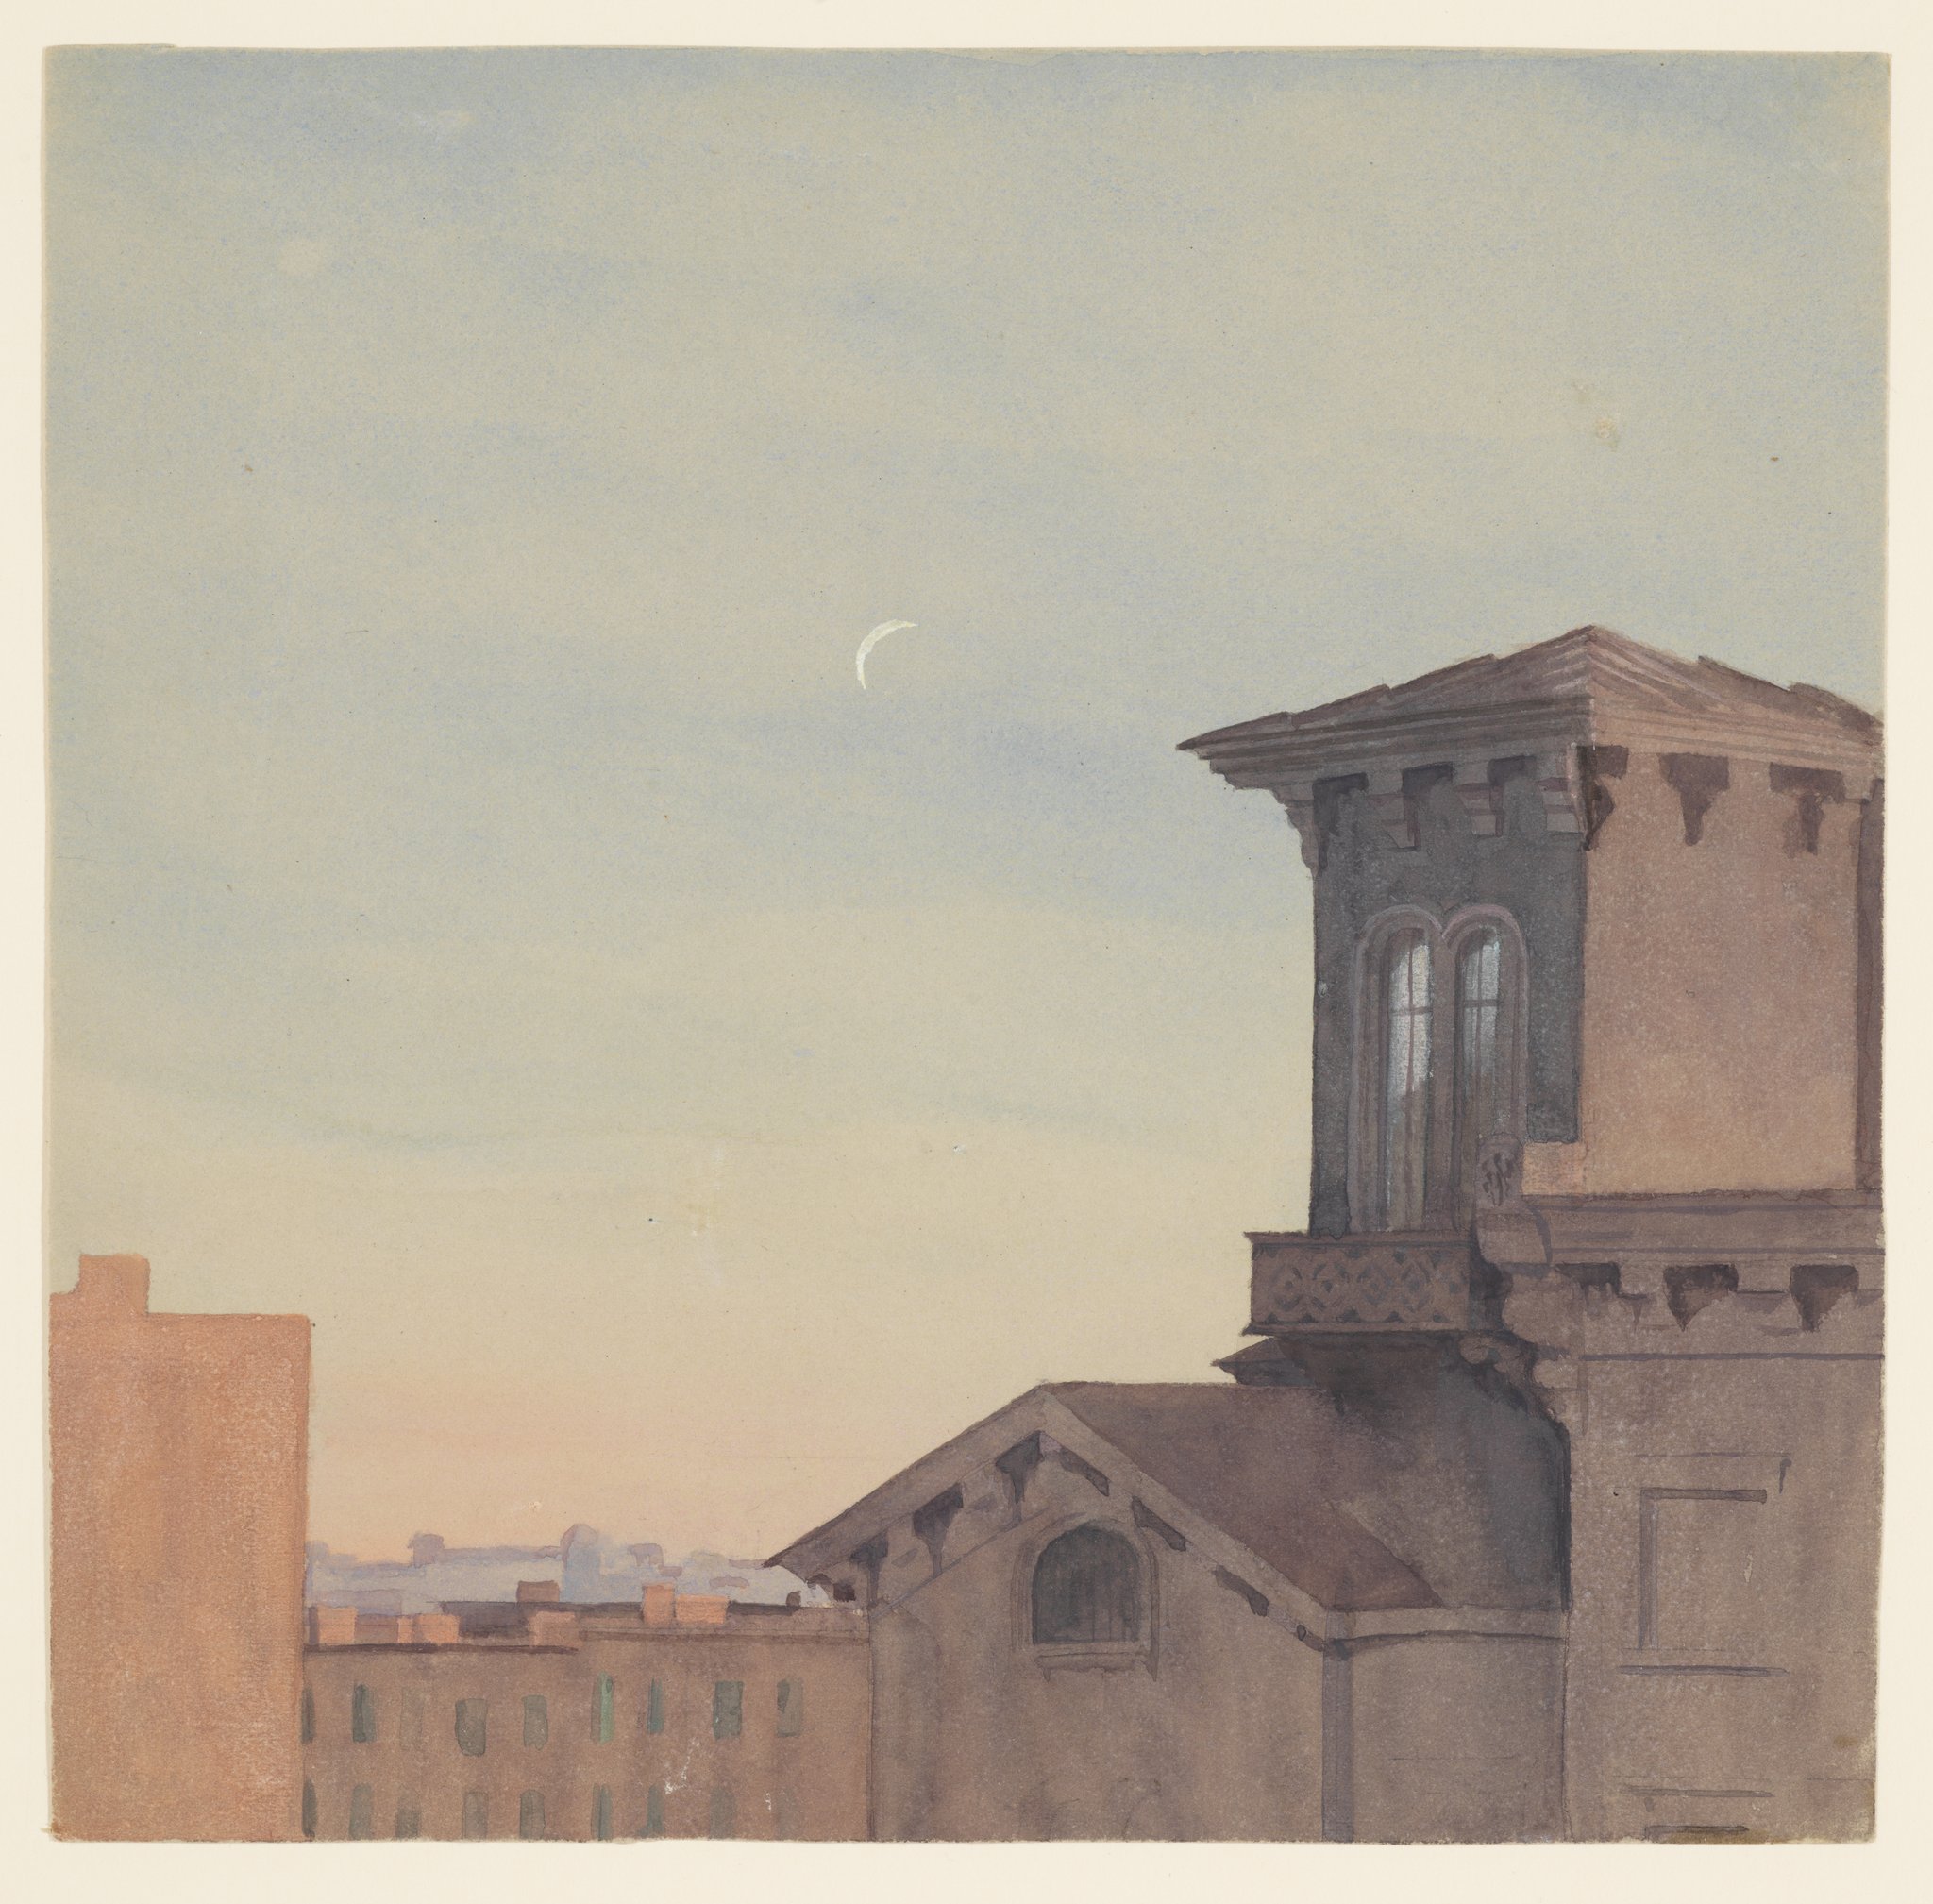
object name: watercolor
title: Rooftops, Brooklyn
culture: american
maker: fidelia bridges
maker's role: artist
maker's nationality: american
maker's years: 1834-1923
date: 1867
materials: gouache, watercolor, paper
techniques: pressed